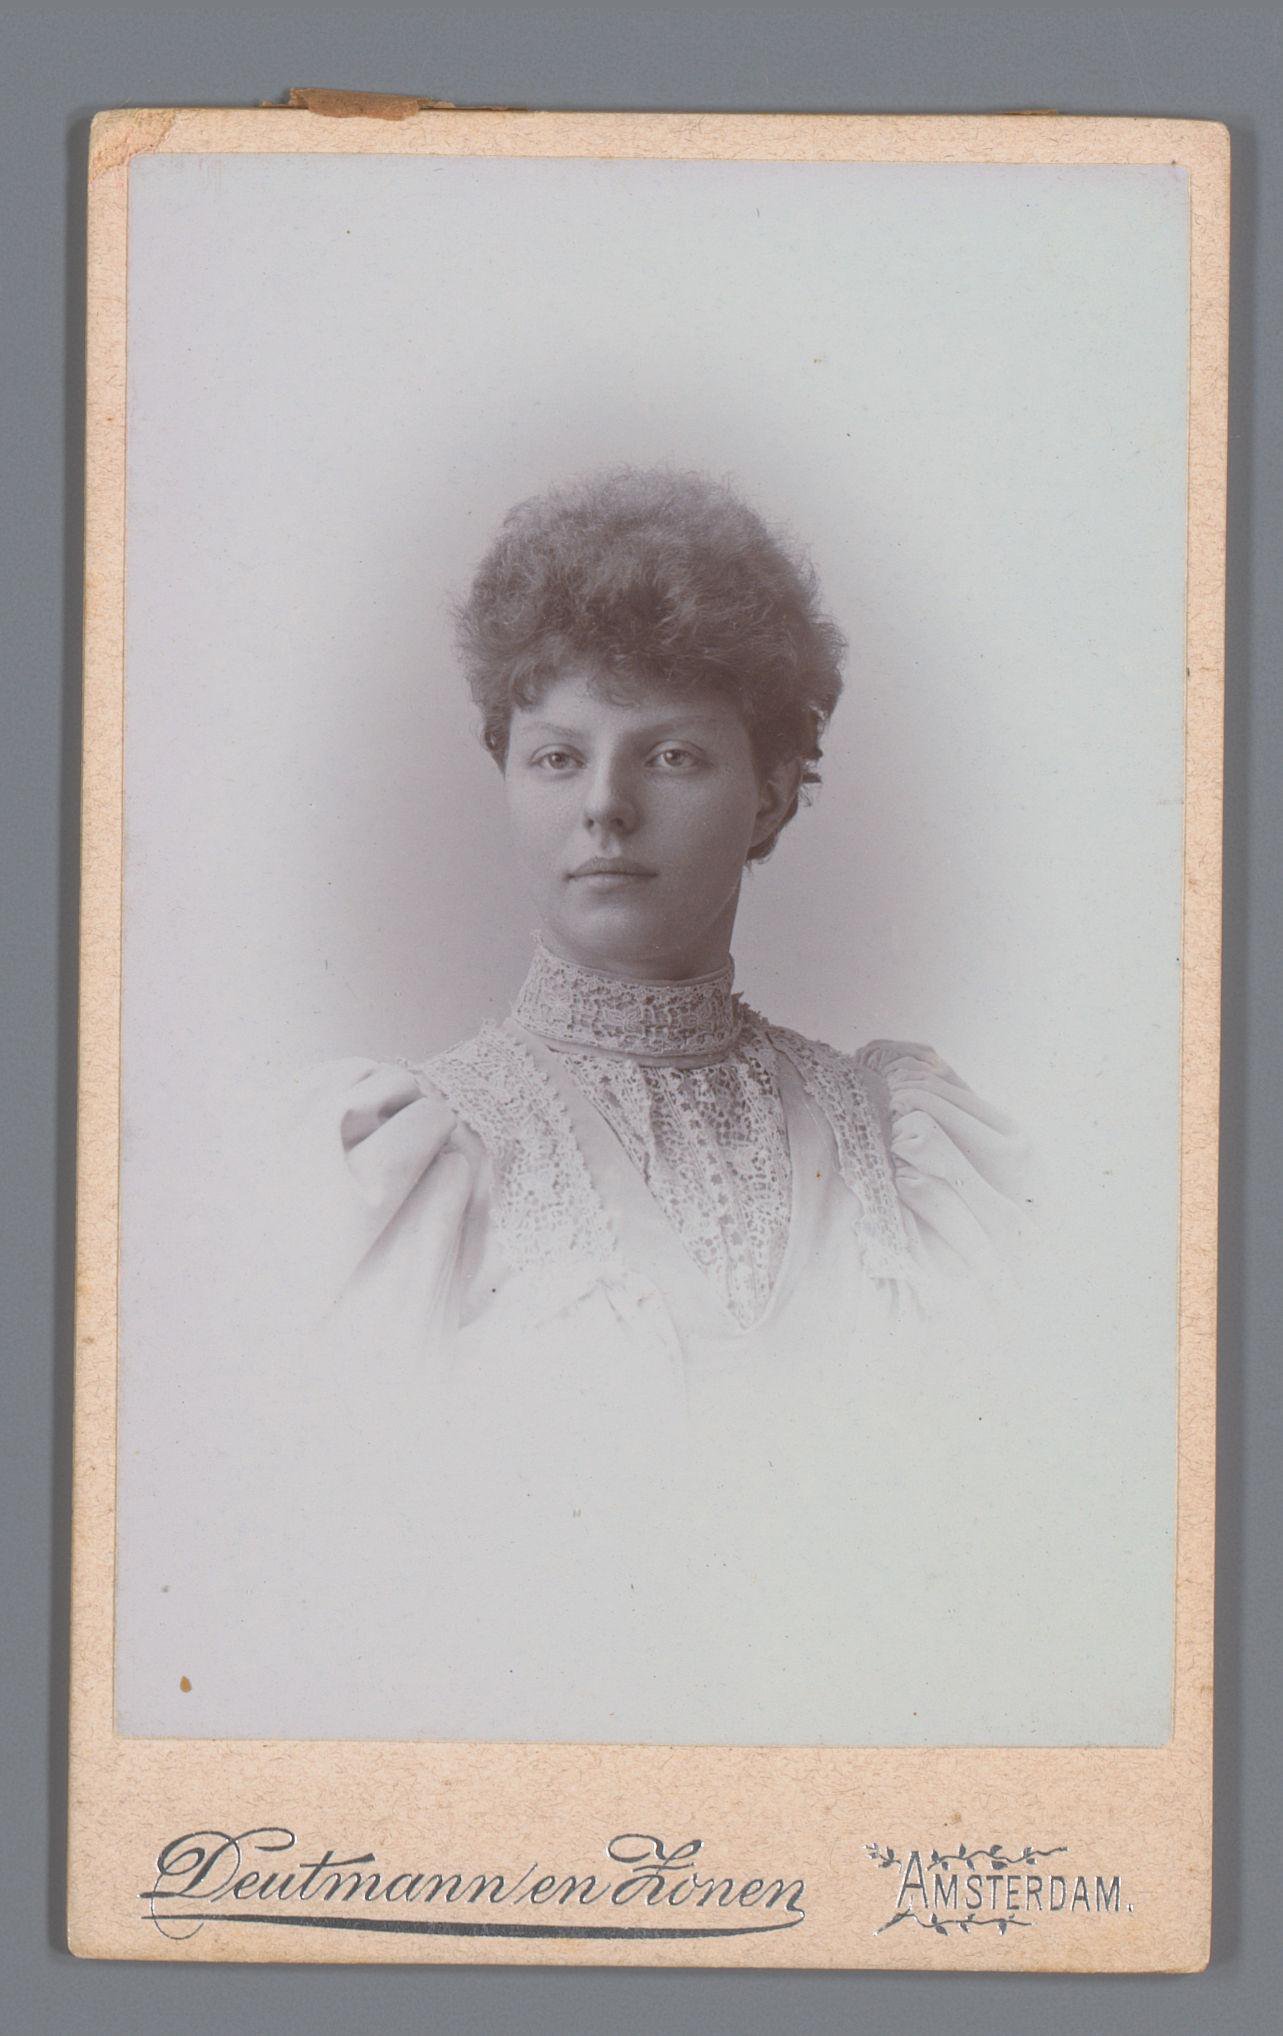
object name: photograph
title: Portret van Charlotte Dentz van Schaik Marloff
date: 1880-1920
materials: cardboard, photographic support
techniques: collodion silver print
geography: amsterdam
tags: historical persons, amsterdam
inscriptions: annotation: ‘Charlotte Dentz van Schaik Marloff’, workshop stamp: ‘Deutmann en Zonen/ Kunstschilders en Photographen/ Amsterdam, Keizersgracht, Hoek Leidschestraat/ 455-457-459-461’